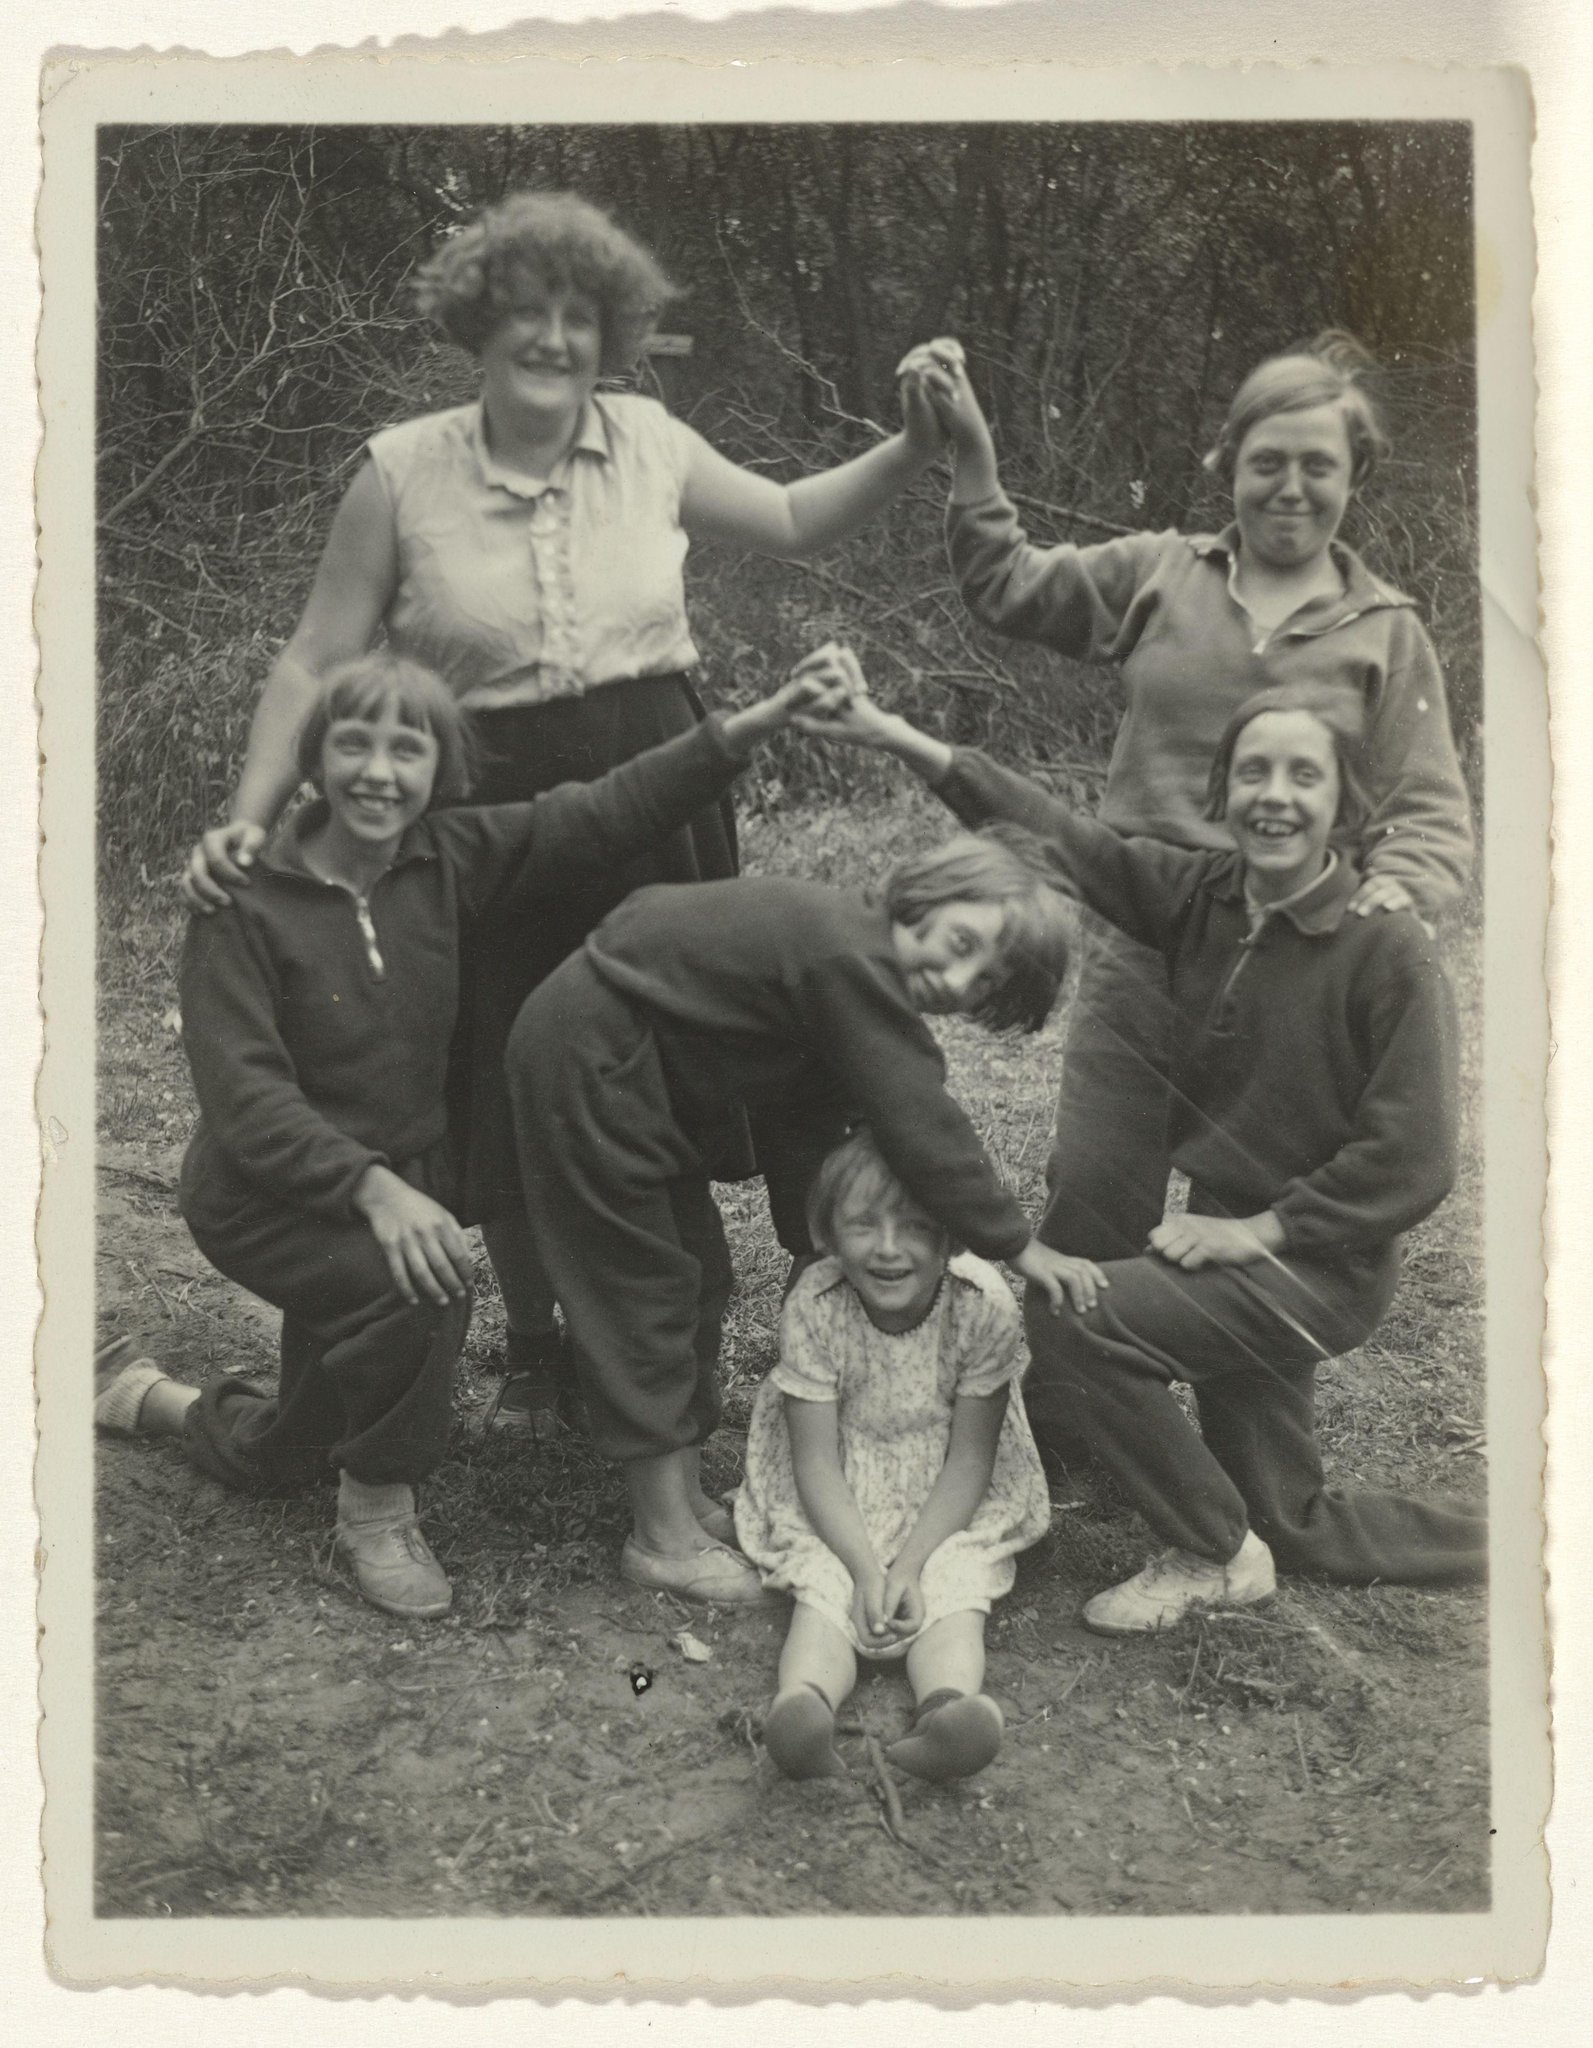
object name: photograph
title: Groepsportret van zes meisjes op het kampeerterrein van Valkeveen, met onder andere Koos Ochse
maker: Anonymous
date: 1930-1940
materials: paper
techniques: gelatin silver print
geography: valkeveen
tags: girl (child between toddler and youth)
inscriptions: inscription: ‘Ivi Aalkema/ Nannie Obbes/ Marietje Obbes/ Puck Obbes/ Ans Robbe/ Koos Ockse/ Het kampeerterrein/ Valkeveen’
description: Portret van zes mensen op het kampeerterrein van Valkeveen. Achterop de foto zijn in potlood hun namen gegeven: Ivi Alkema, Nannie Obbes, Merietje Obbes, Puck Obbes, Ans Robbe en Koos Ochse.